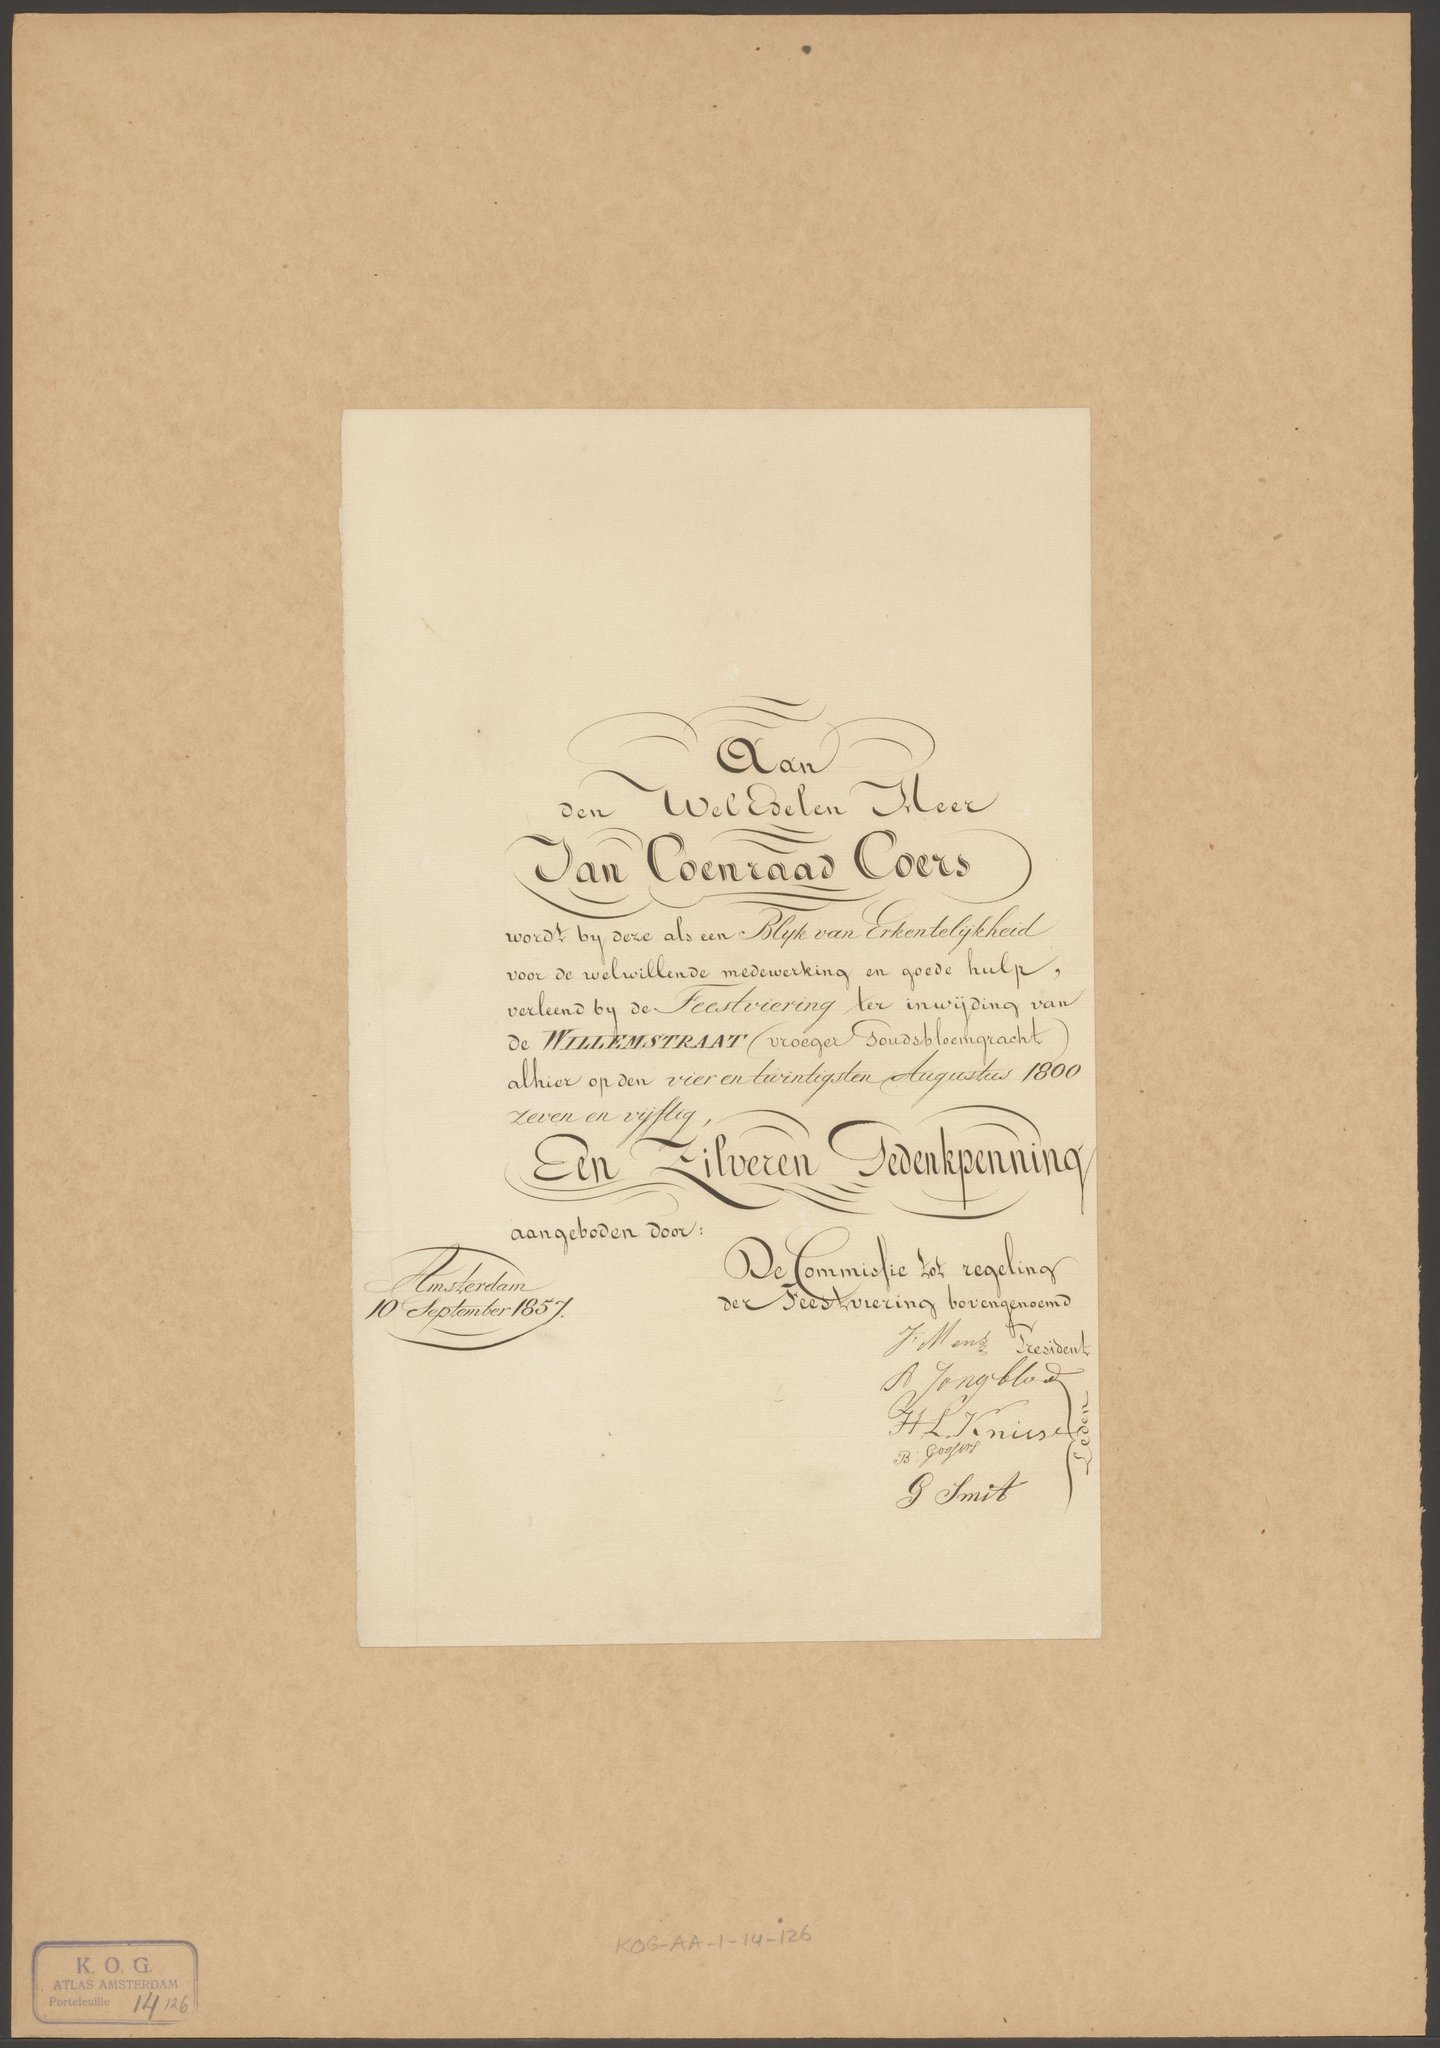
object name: medal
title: Tekst over het aanbieden van een gedenkpenning aan de heer Jan Coenraad Coers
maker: Anonymous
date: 1857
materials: ink, paper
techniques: pen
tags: handwriting, written text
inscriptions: collector's mark: ‘14.126’ Lugt 1641b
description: Onderwerpsrubriek binnen de Atlas Amsterdam: Waal (Kromme en Oude), Walenpleintje, Warmoesgracht, Warmoesstraat, Waterlooplein, Westerdoksdijk, Westermarkt, Weteringschans, Willemspark, Willemsstraat, Wittenburg, Wittenkade (de), Wittenstraat (de).